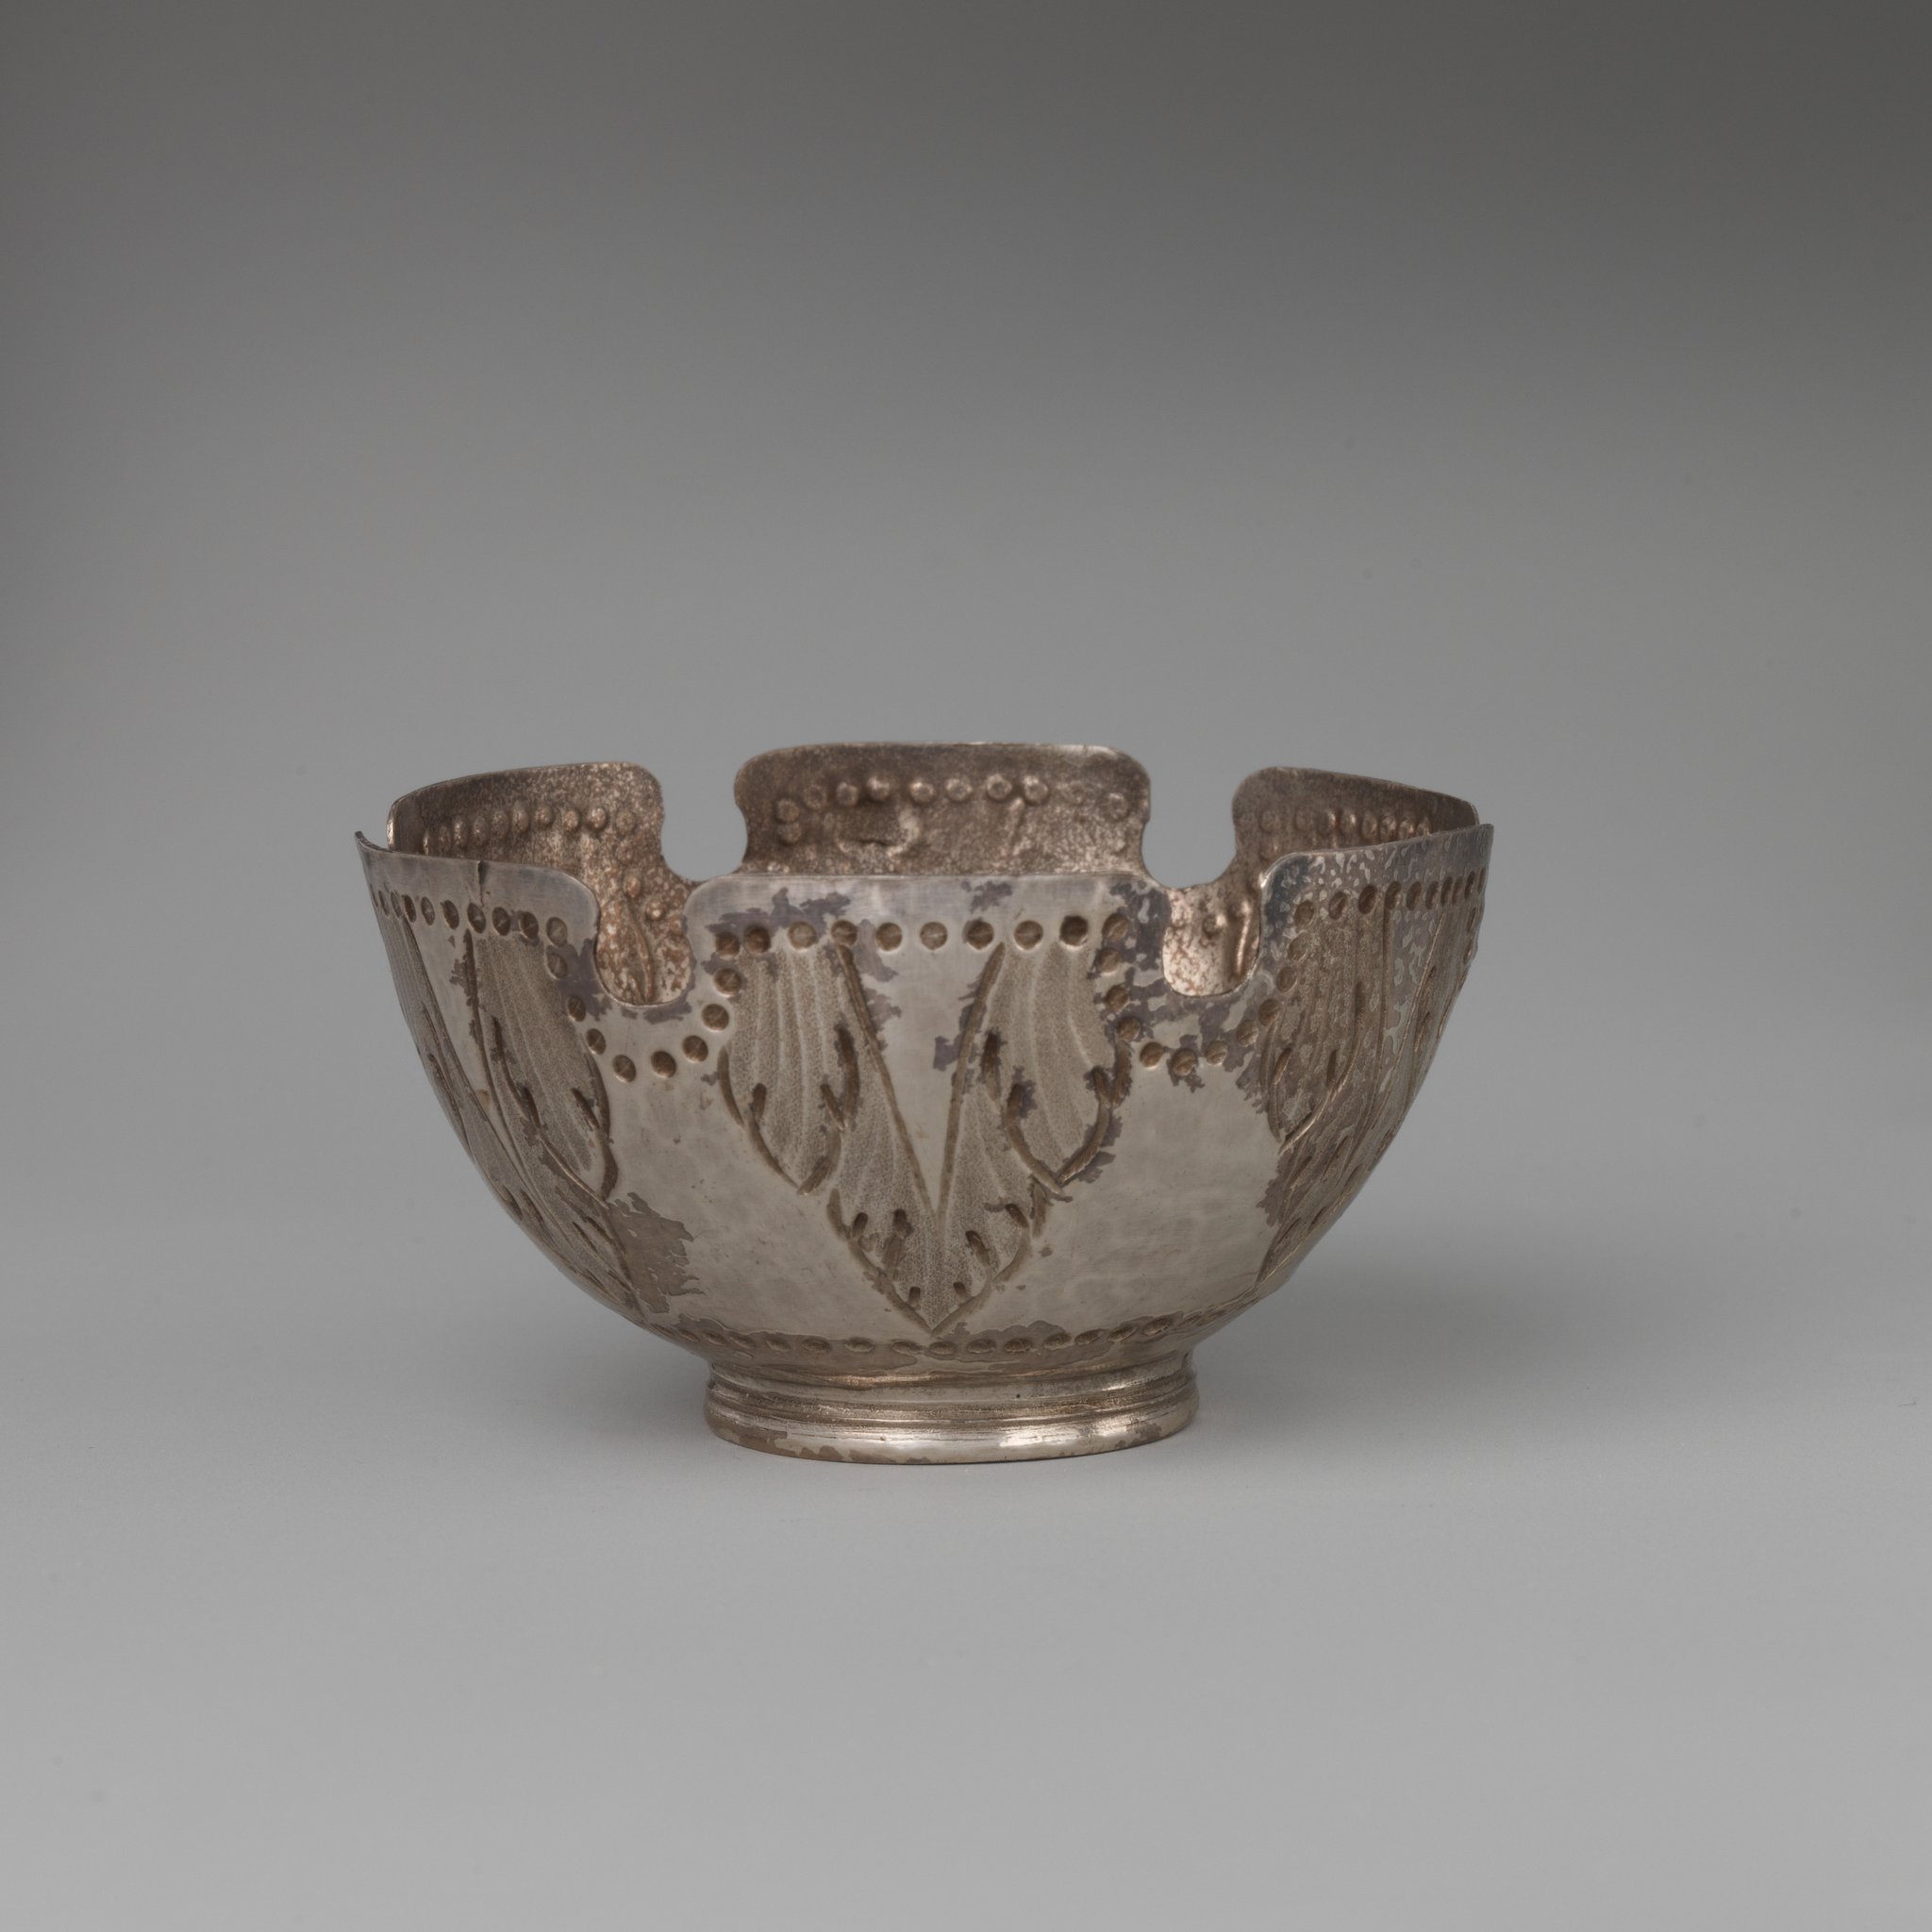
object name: monteith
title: Miniature monteith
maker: george manjoy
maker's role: maker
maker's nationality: british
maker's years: 1685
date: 1693-1694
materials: silver